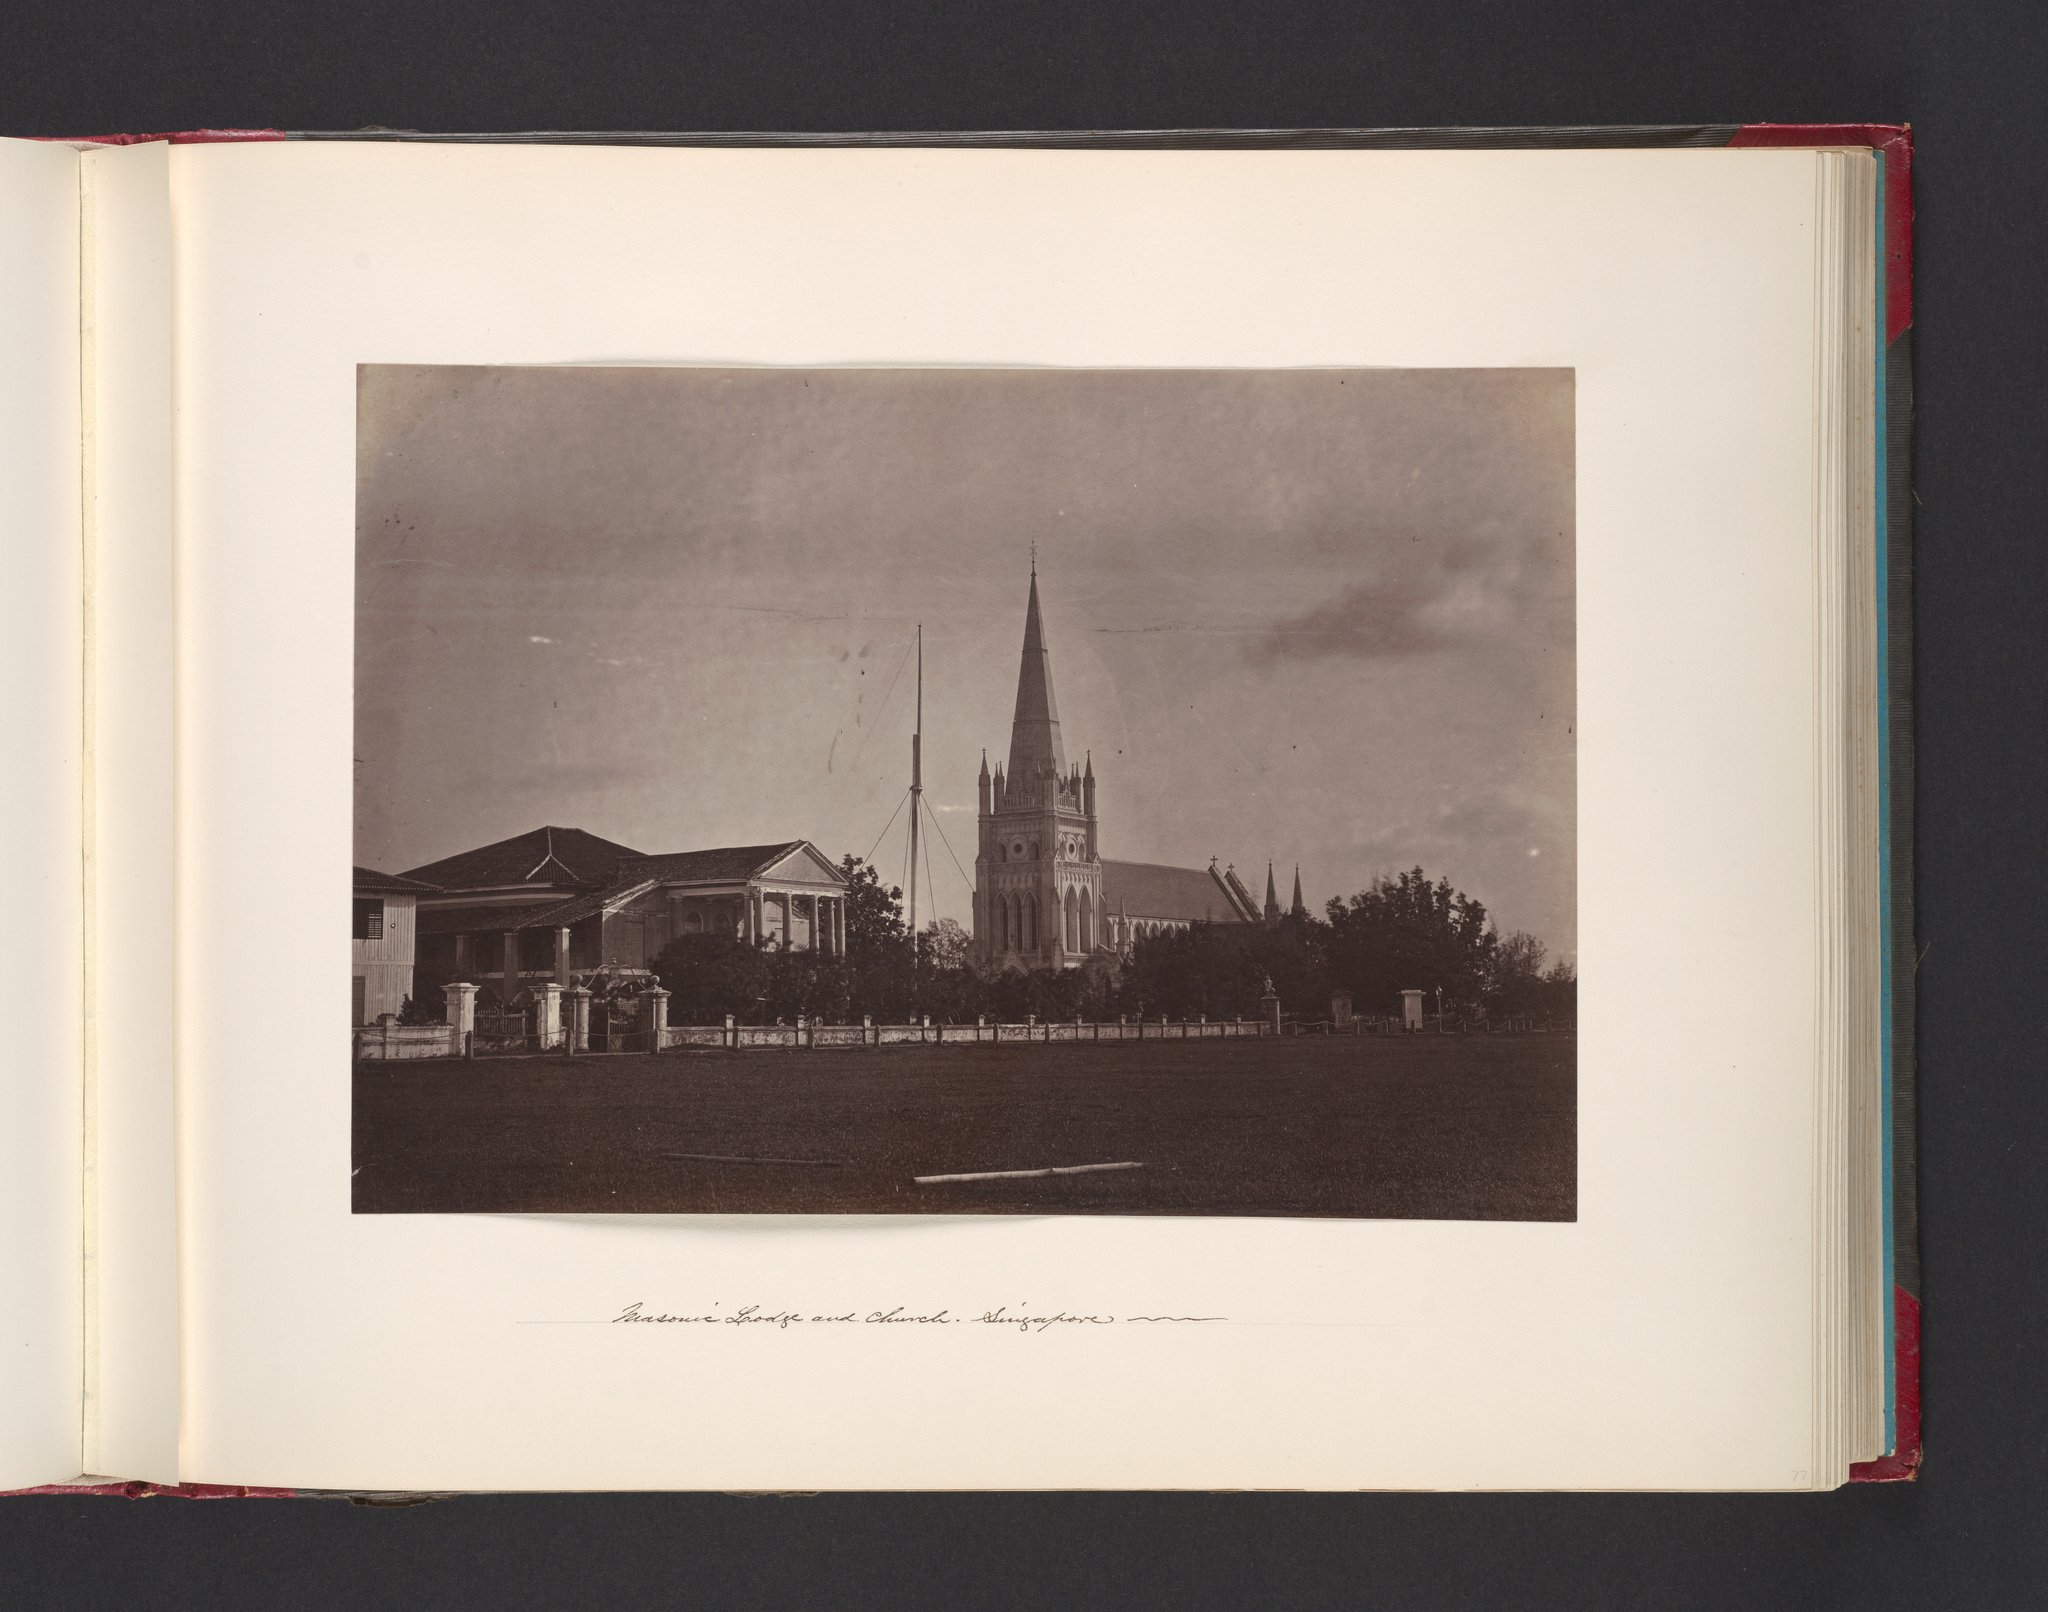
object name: photograph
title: Masonic Lodge and Church. Singapore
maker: john thomson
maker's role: artist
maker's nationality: british, scottish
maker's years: 1837-1921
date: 1865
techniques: albumen silver print, glass negative